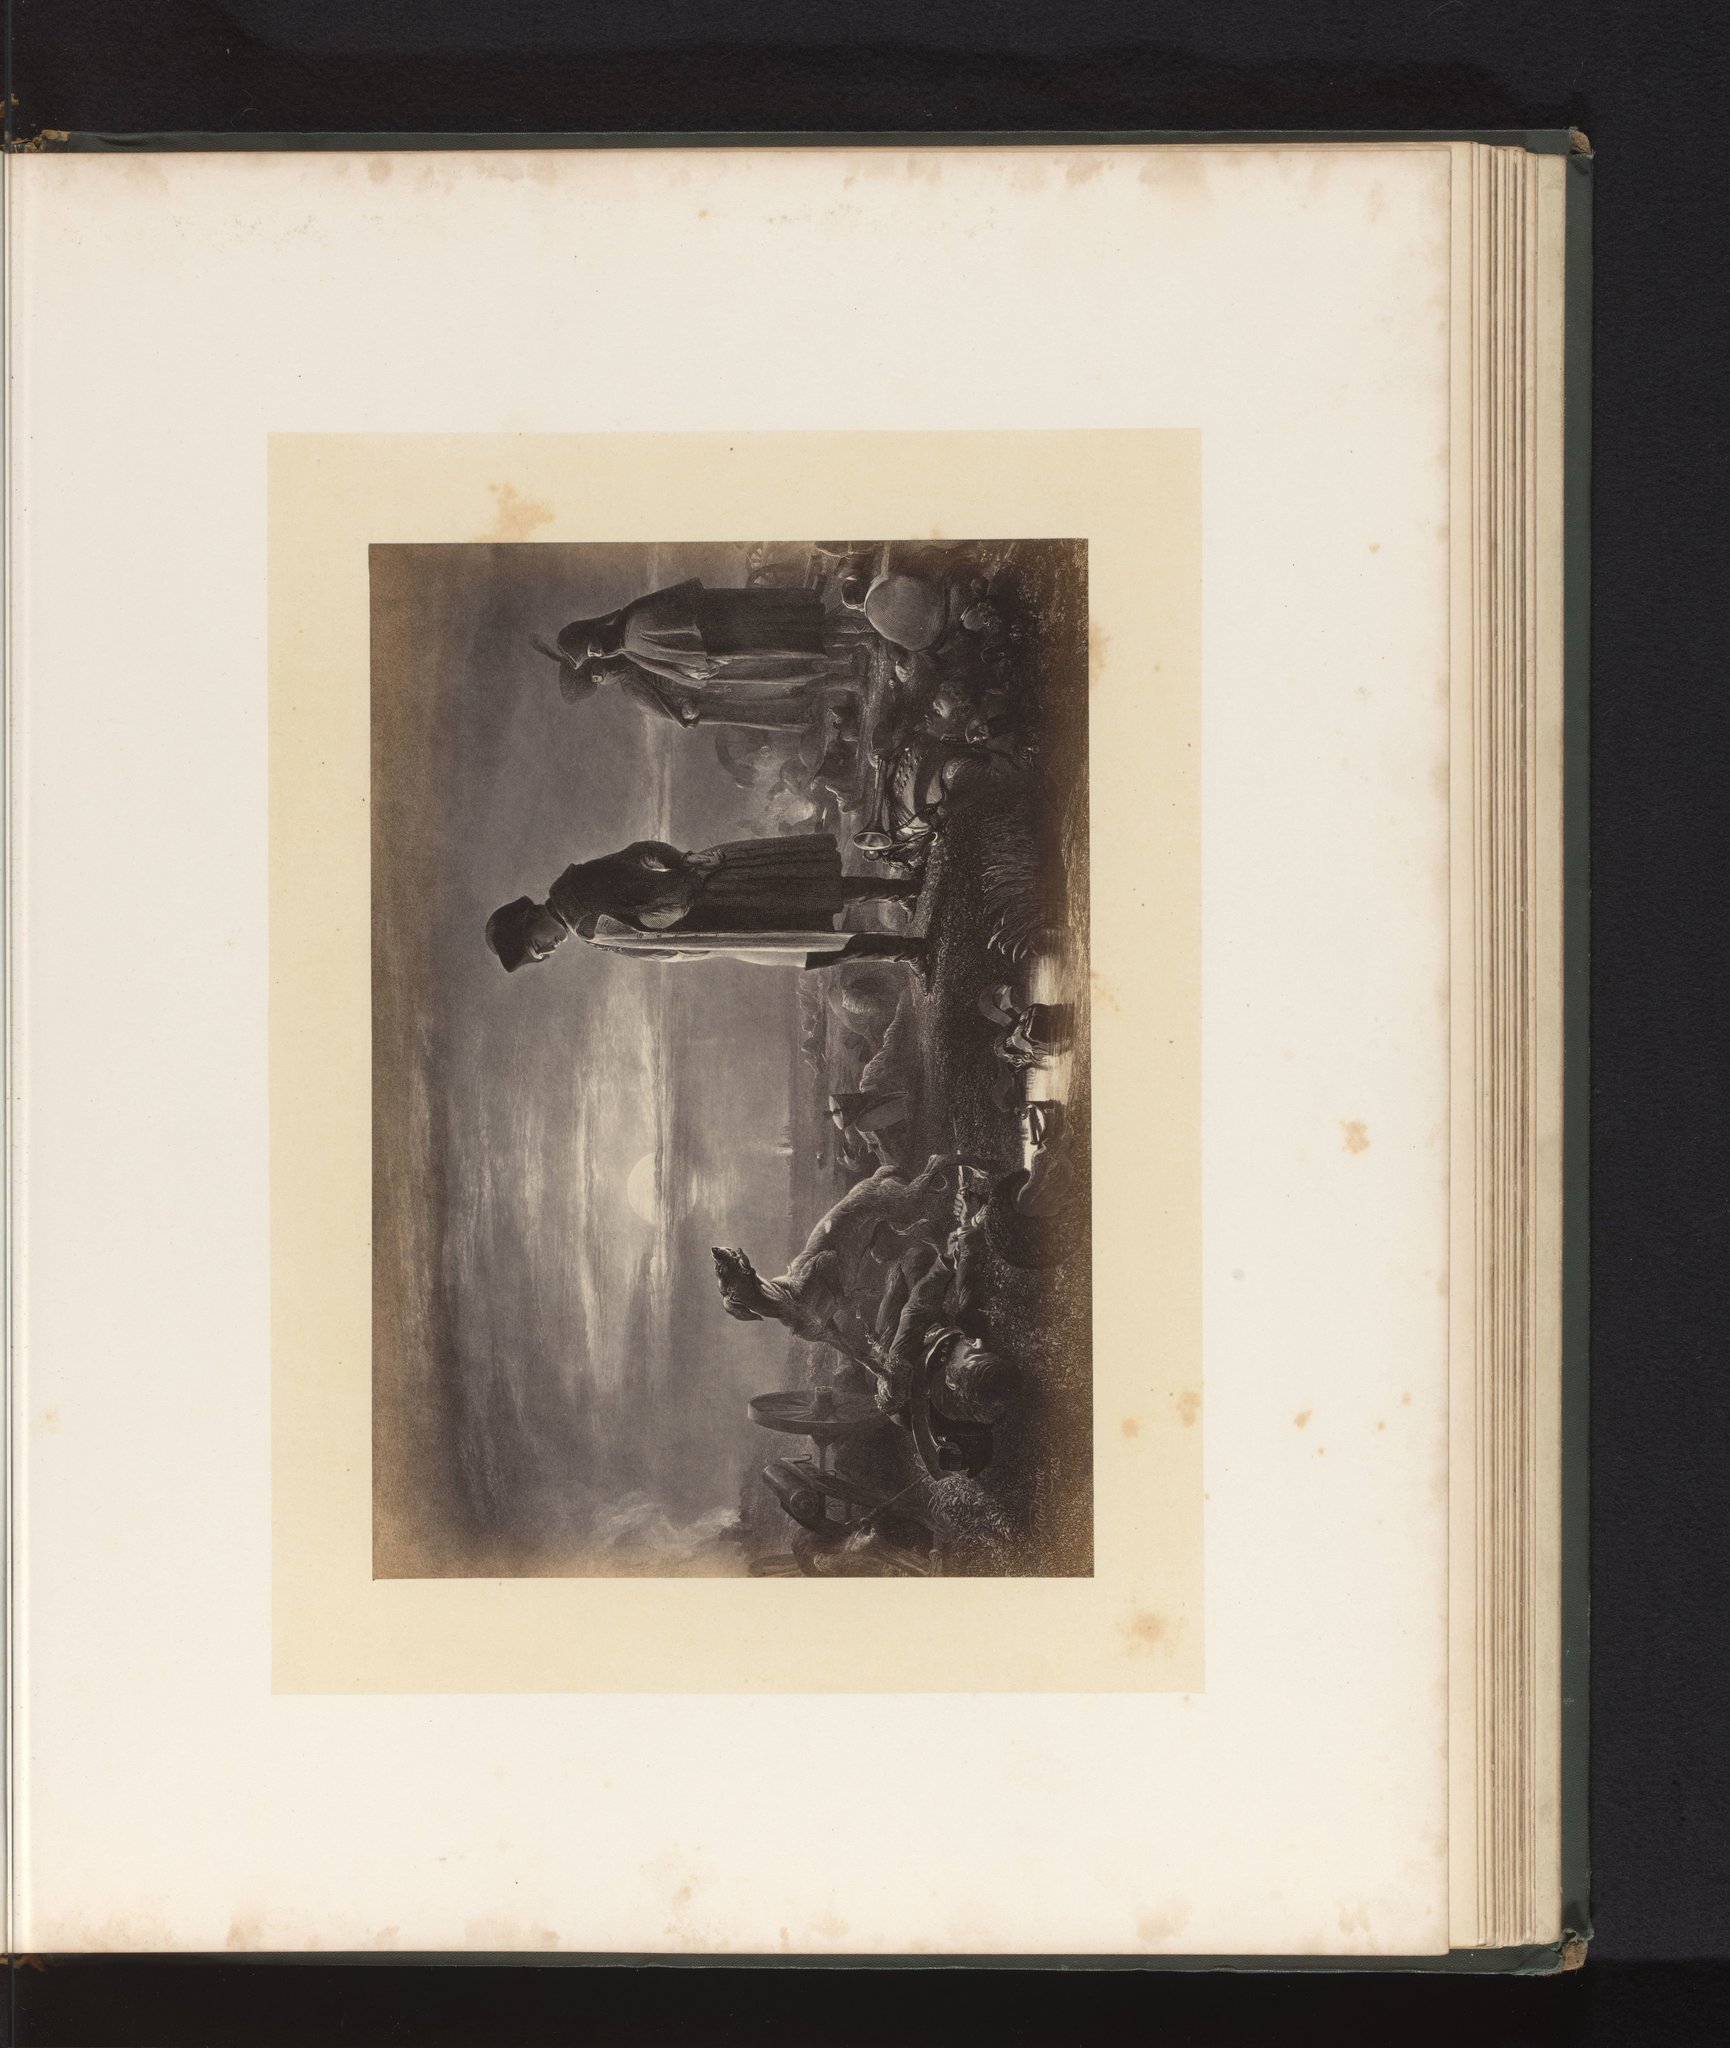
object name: reproduction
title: Fotoreproductie van een gravure van Incident in the Life of Napoleon, naar het schilderij door Sir George Harvey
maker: thomas annan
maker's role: fotograaf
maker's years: 1829-1887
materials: photographic support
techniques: albumen print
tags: napoleon i (emperor of the french), emperor, the defeated (after the battle)